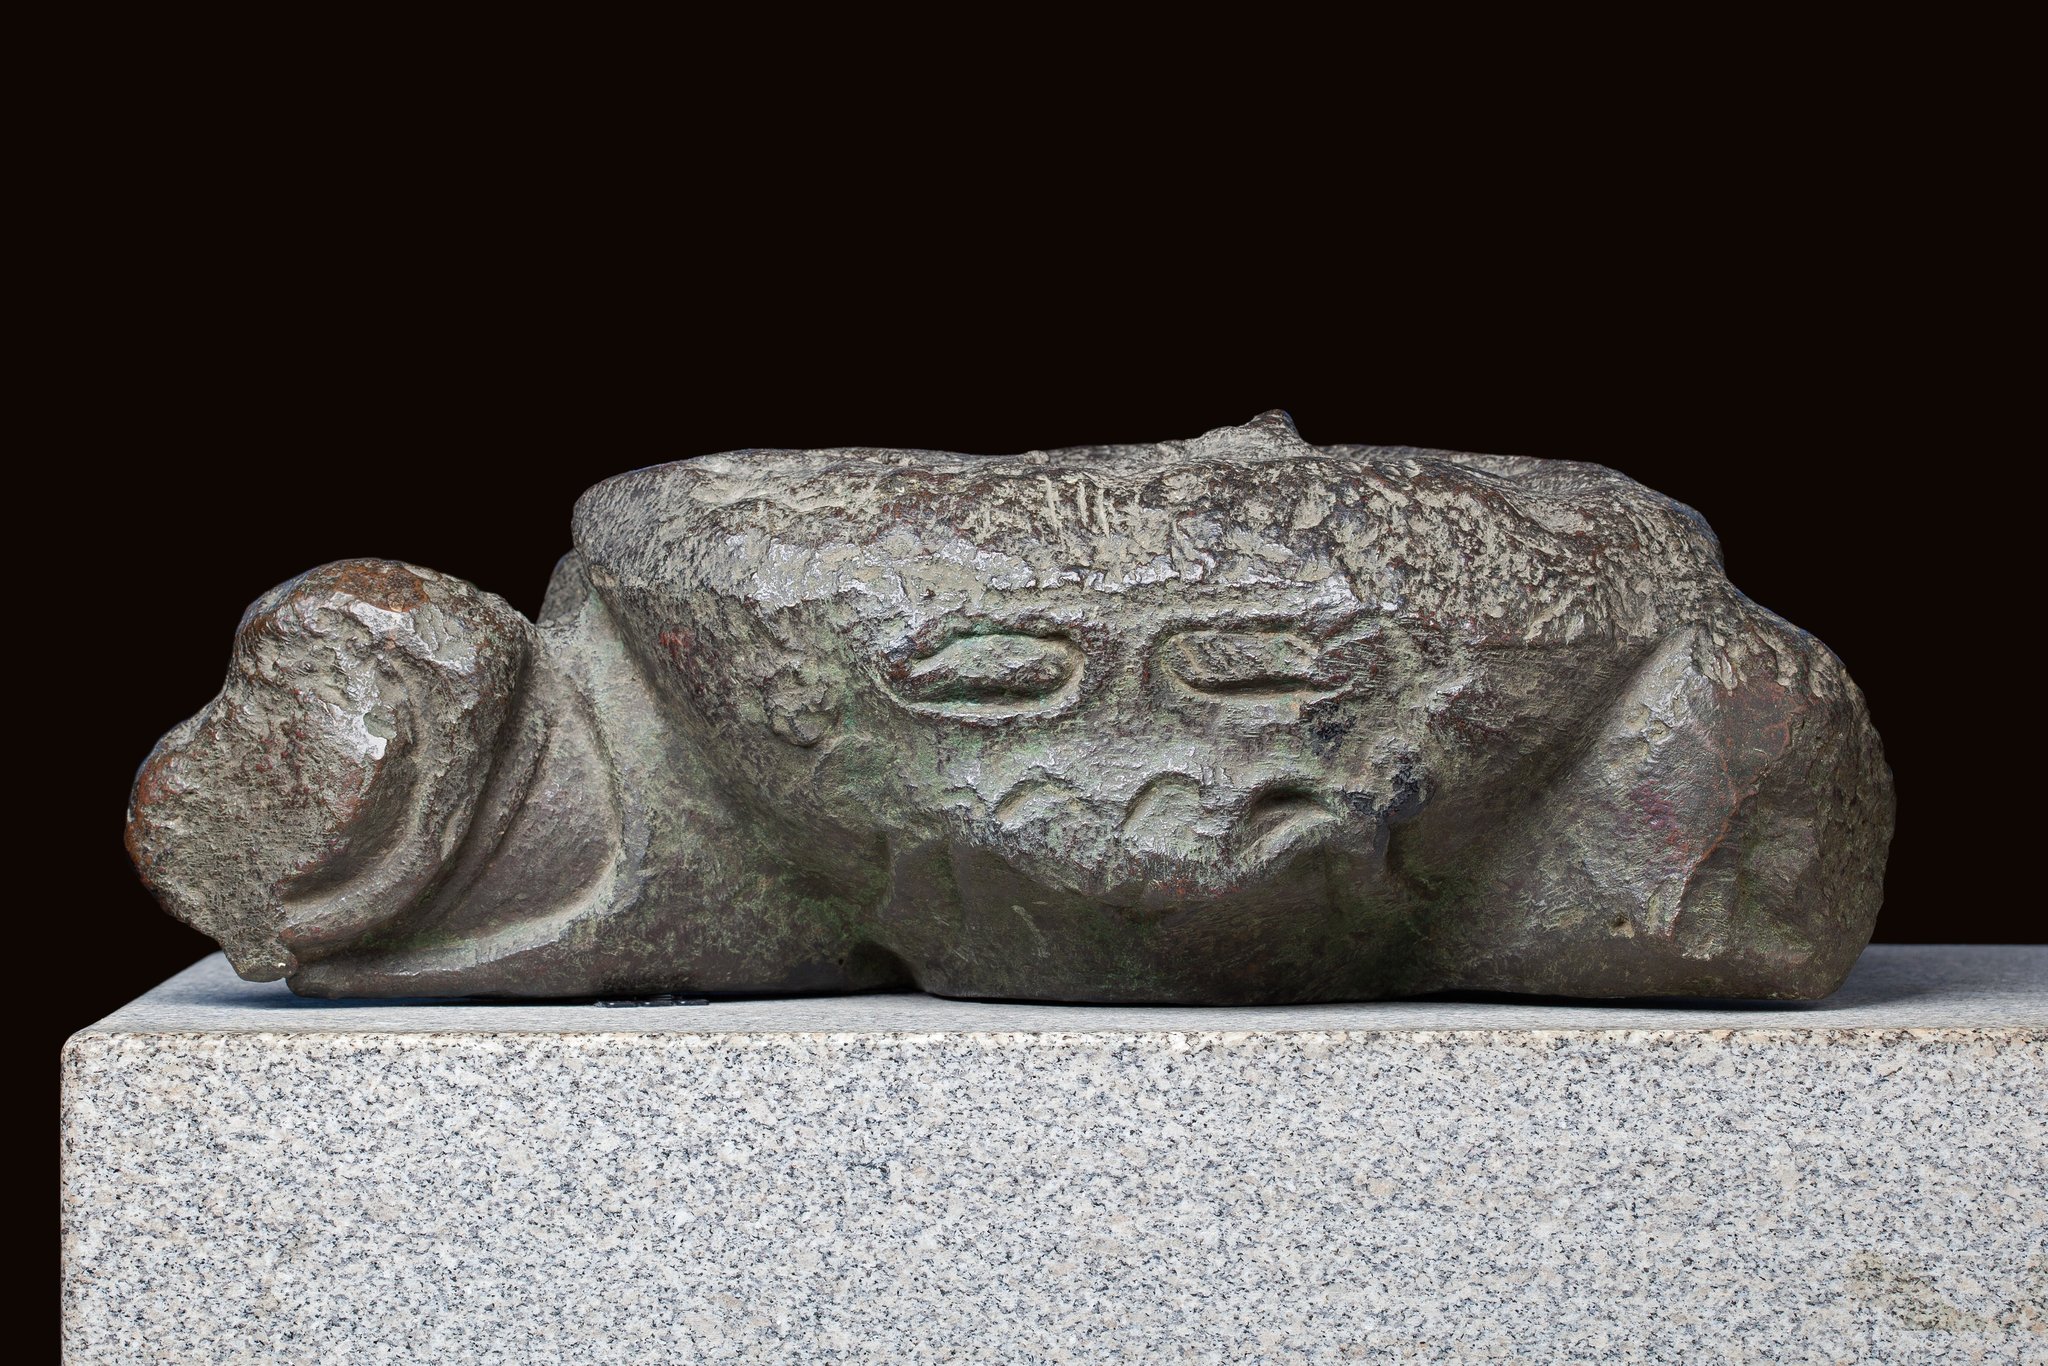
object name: obelisk support, crab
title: Crab from "Cleopatra's Needle"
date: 13 BCE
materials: bronze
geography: egypt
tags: crabs